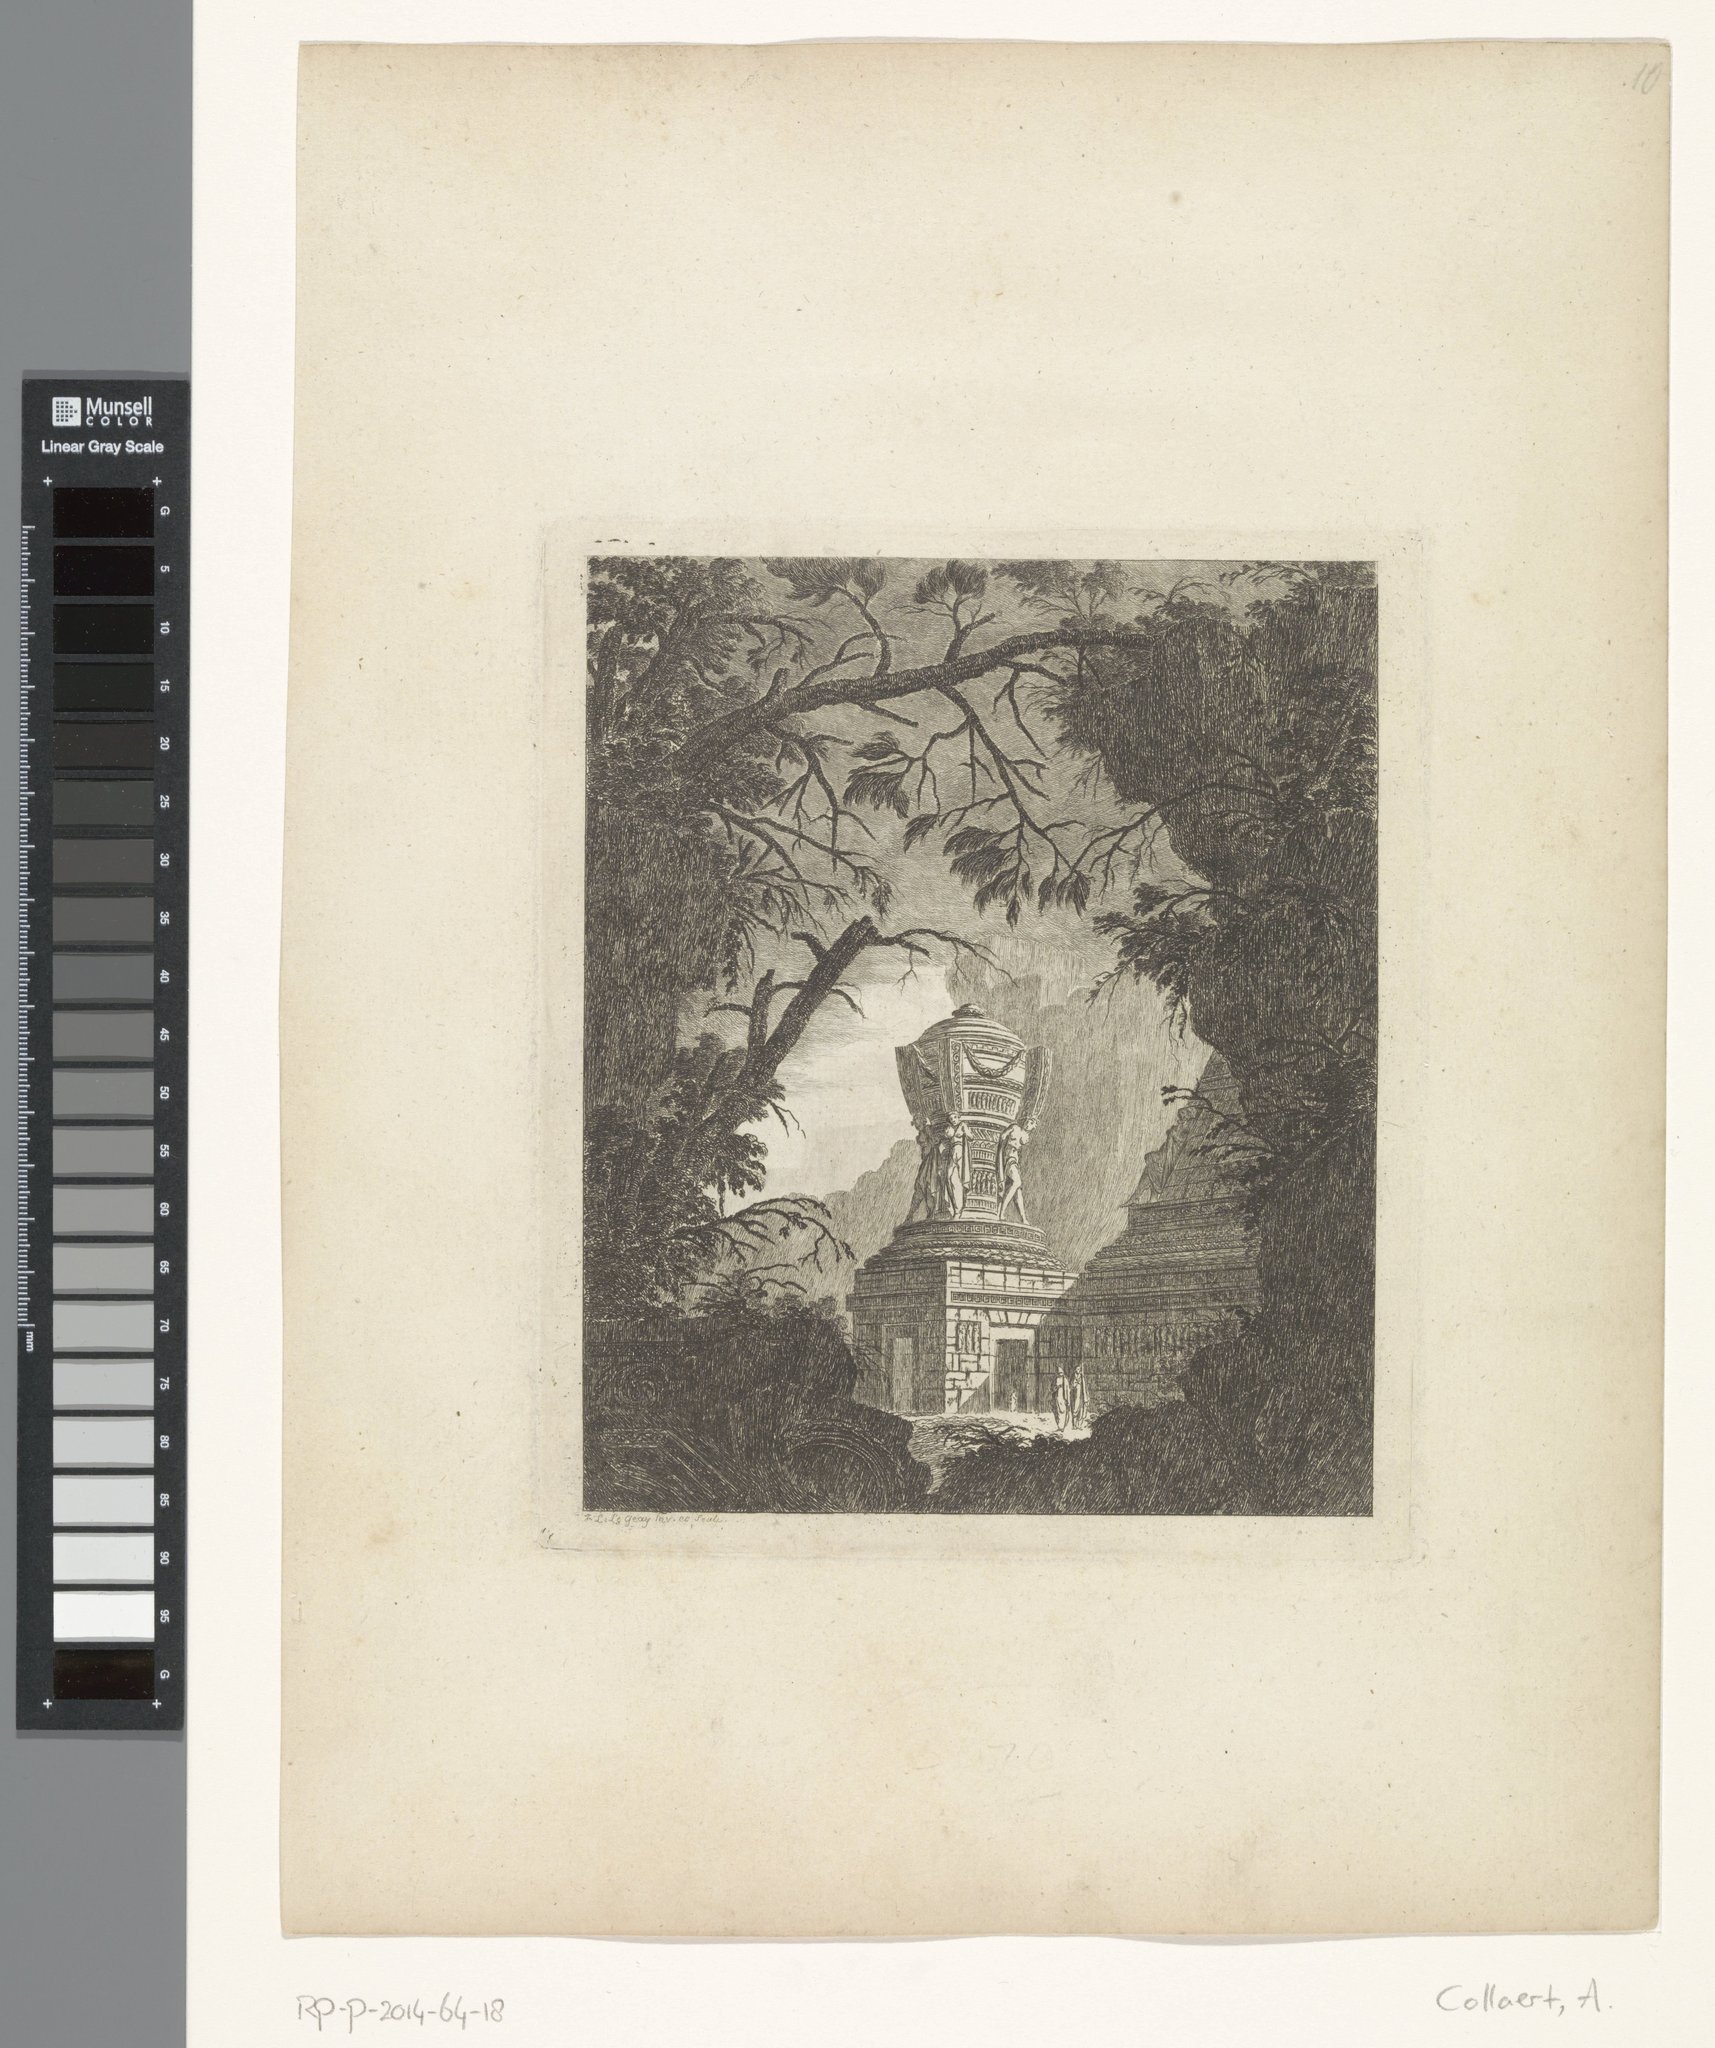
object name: ornament print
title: Tombe met groteske vaas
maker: jean laurent legeay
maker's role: print maker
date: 1767-1770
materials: paper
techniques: etching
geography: france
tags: vase ~ ornament, landscape with ruins, grave-building, monumental tomb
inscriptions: collector's mark: Lugt 2228, collector's mark: Lugt 2760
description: Tombe bekroond met een groteske vaas gedragen door figuren. Onderdeel van groep prenten afkomstig uit één van de vier series van vazen, ruïnes, tombes en fonteinen met in totaal ca. 25 bladen.